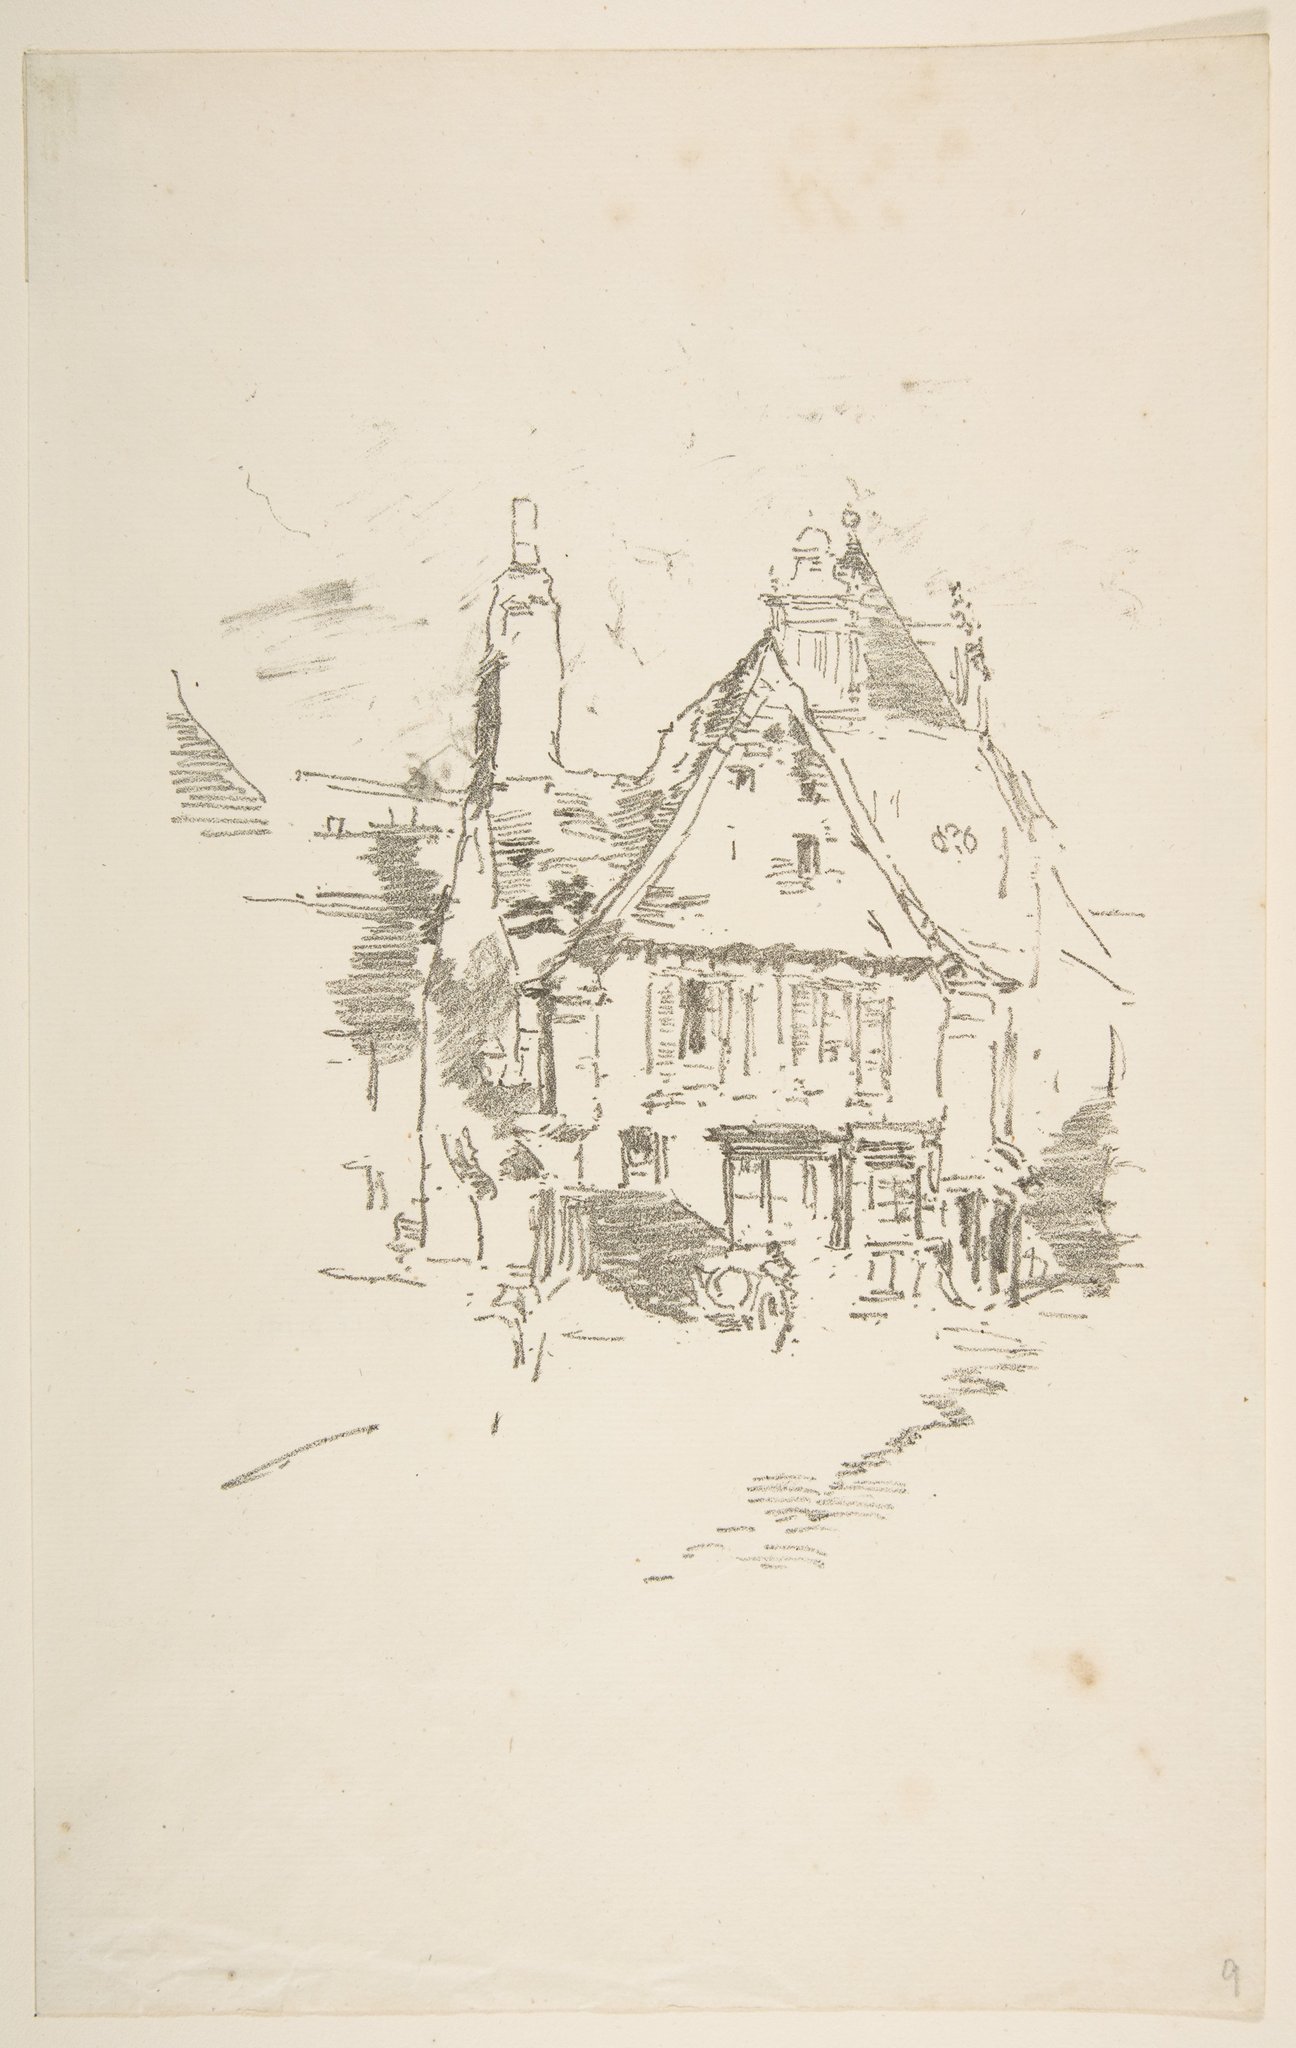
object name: print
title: Gabled Roofs, Vitré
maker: james mcneill whistler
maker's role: artist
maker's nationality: american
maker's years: 1834-1903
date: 1893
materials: ink, paper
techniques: printing, stumping, lithography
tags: buildings